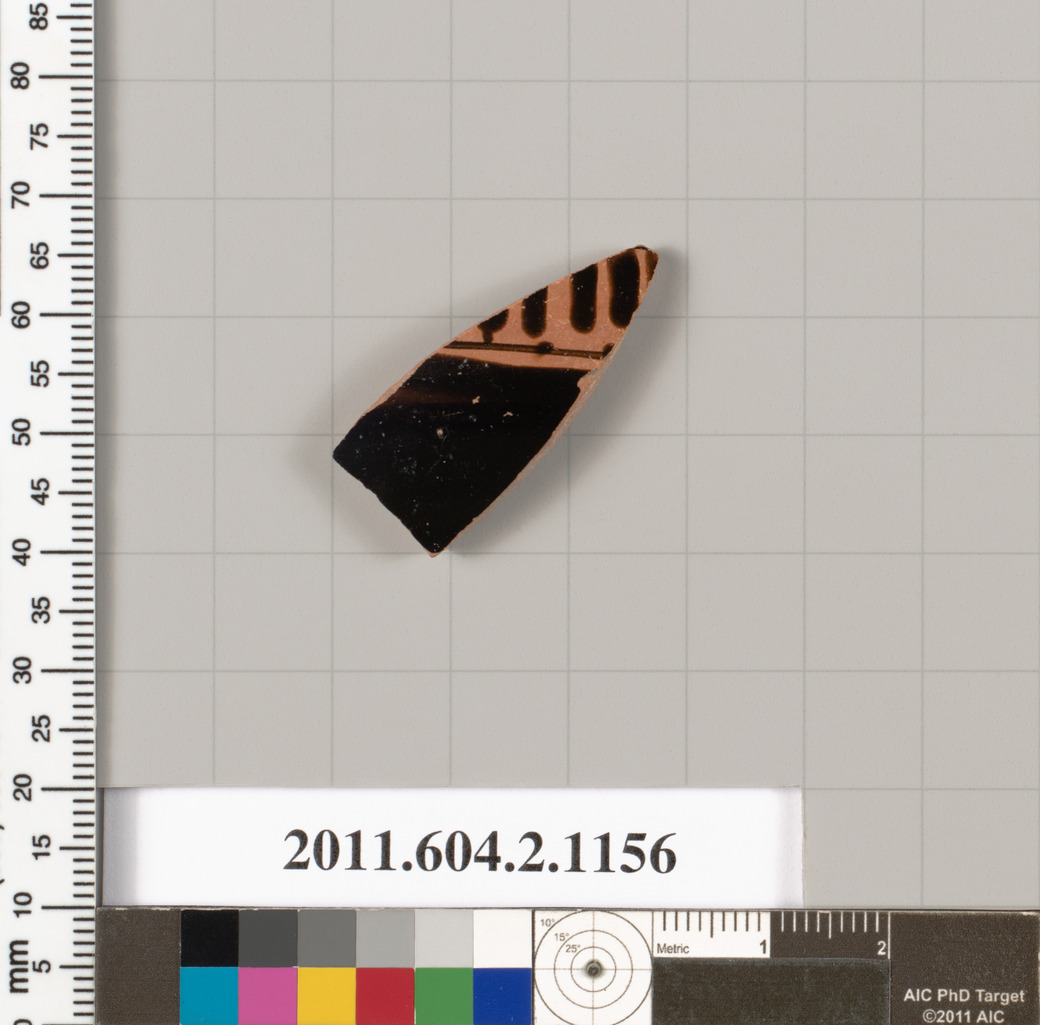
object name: oinochoe fragment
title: Terracotta fragment of an oinochoe (jug)?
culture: greek, attic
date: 450-426 BCE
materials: terracotta